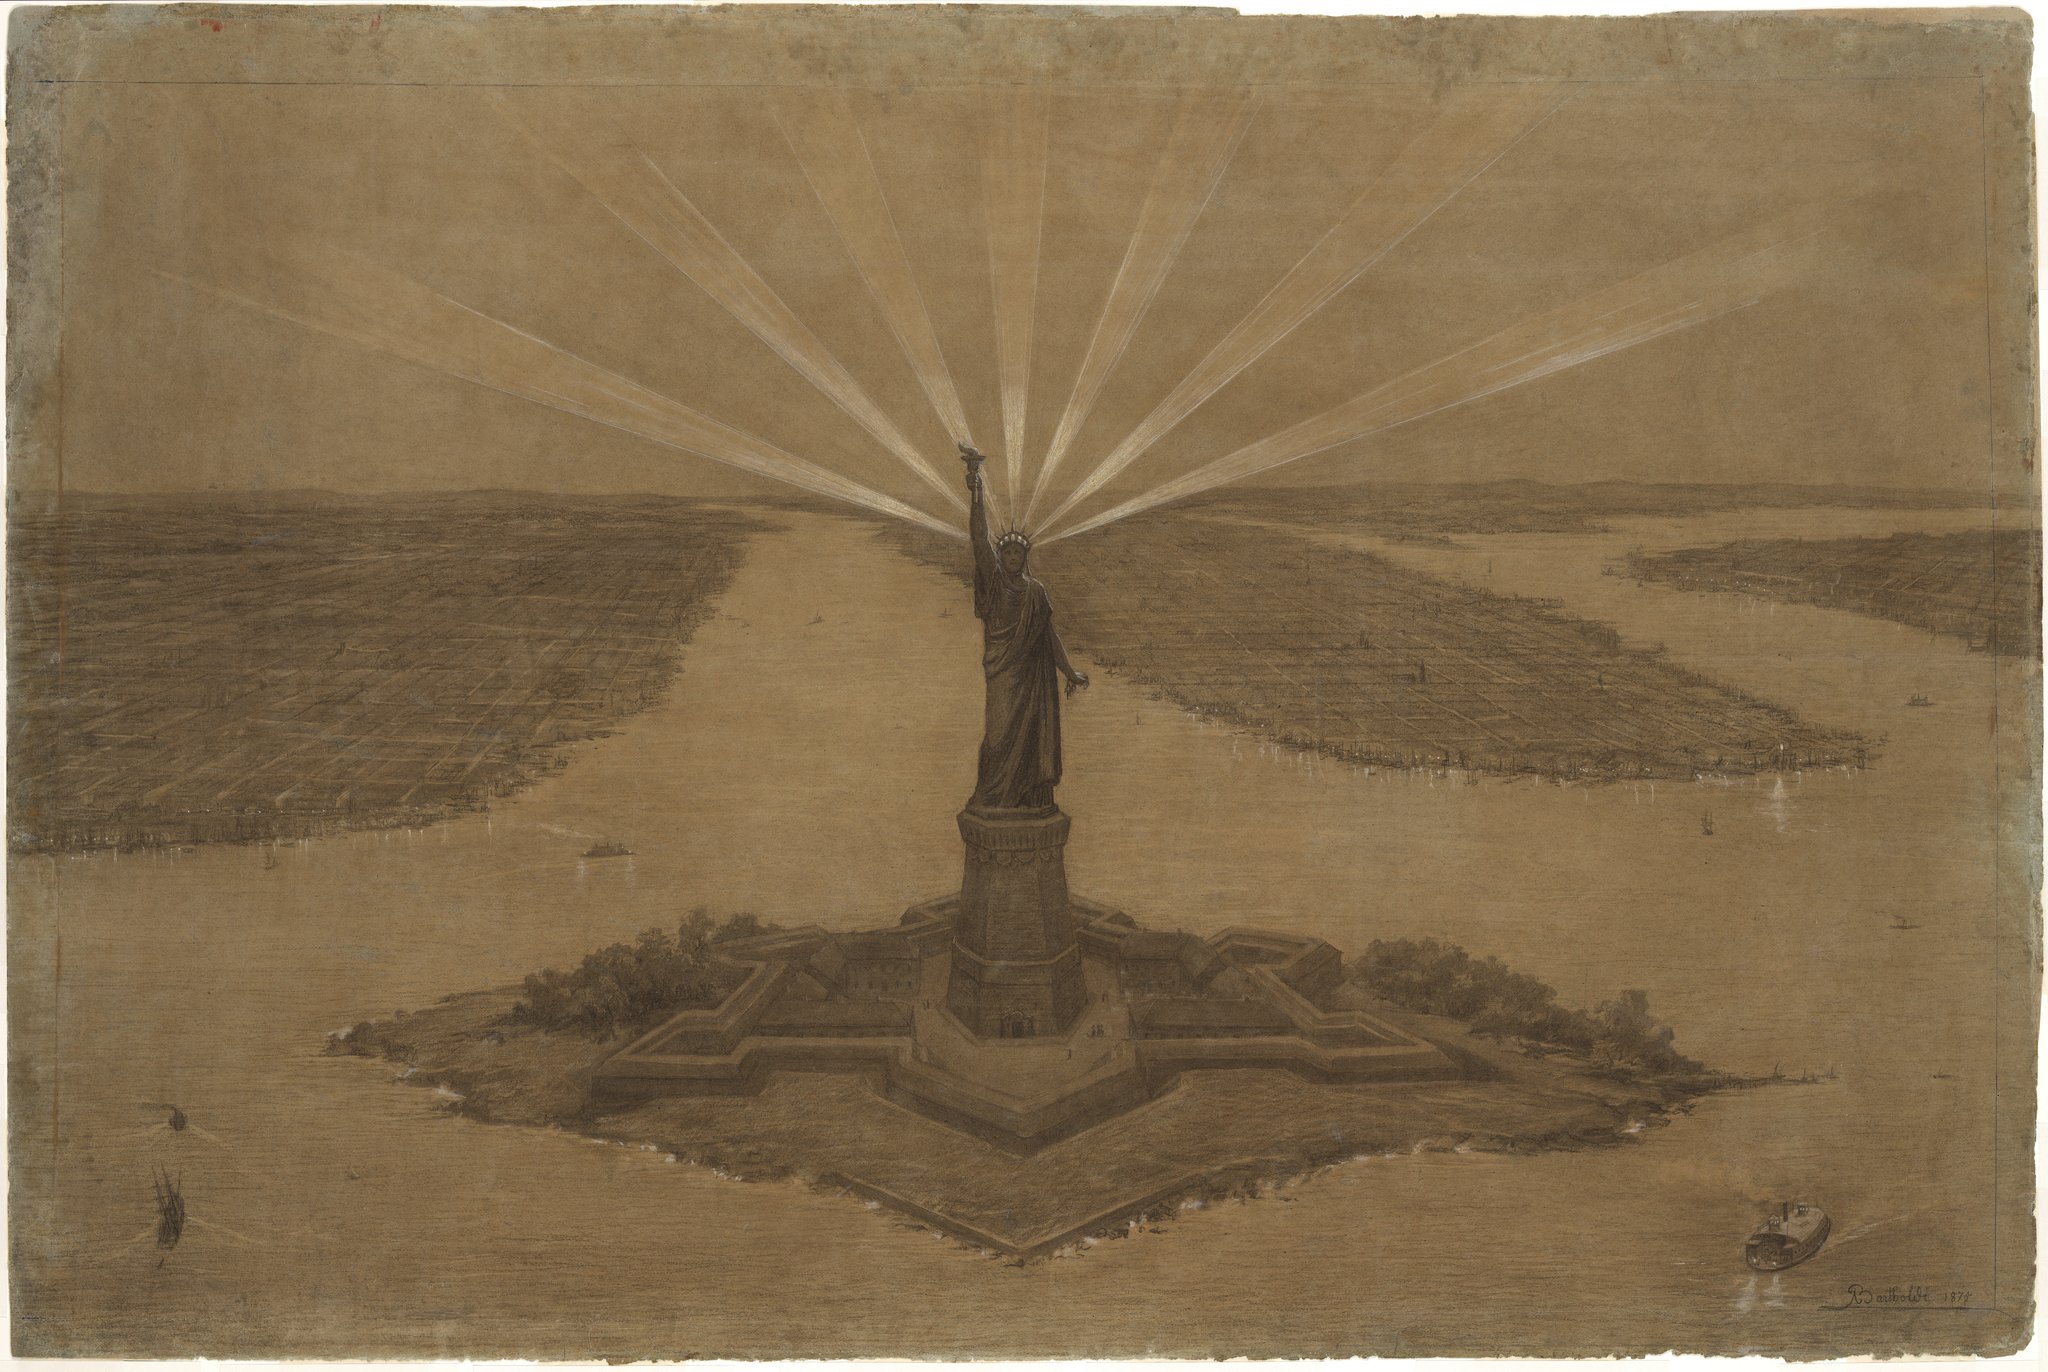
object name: drawing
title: Presentation Drawing of "The Statue of Liberty Illuminating the World"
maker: frédéric-auguste bartholdi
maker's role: artist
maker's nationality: french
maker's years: 1834-1904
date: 1875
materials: chalk, charcoal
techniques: heightening